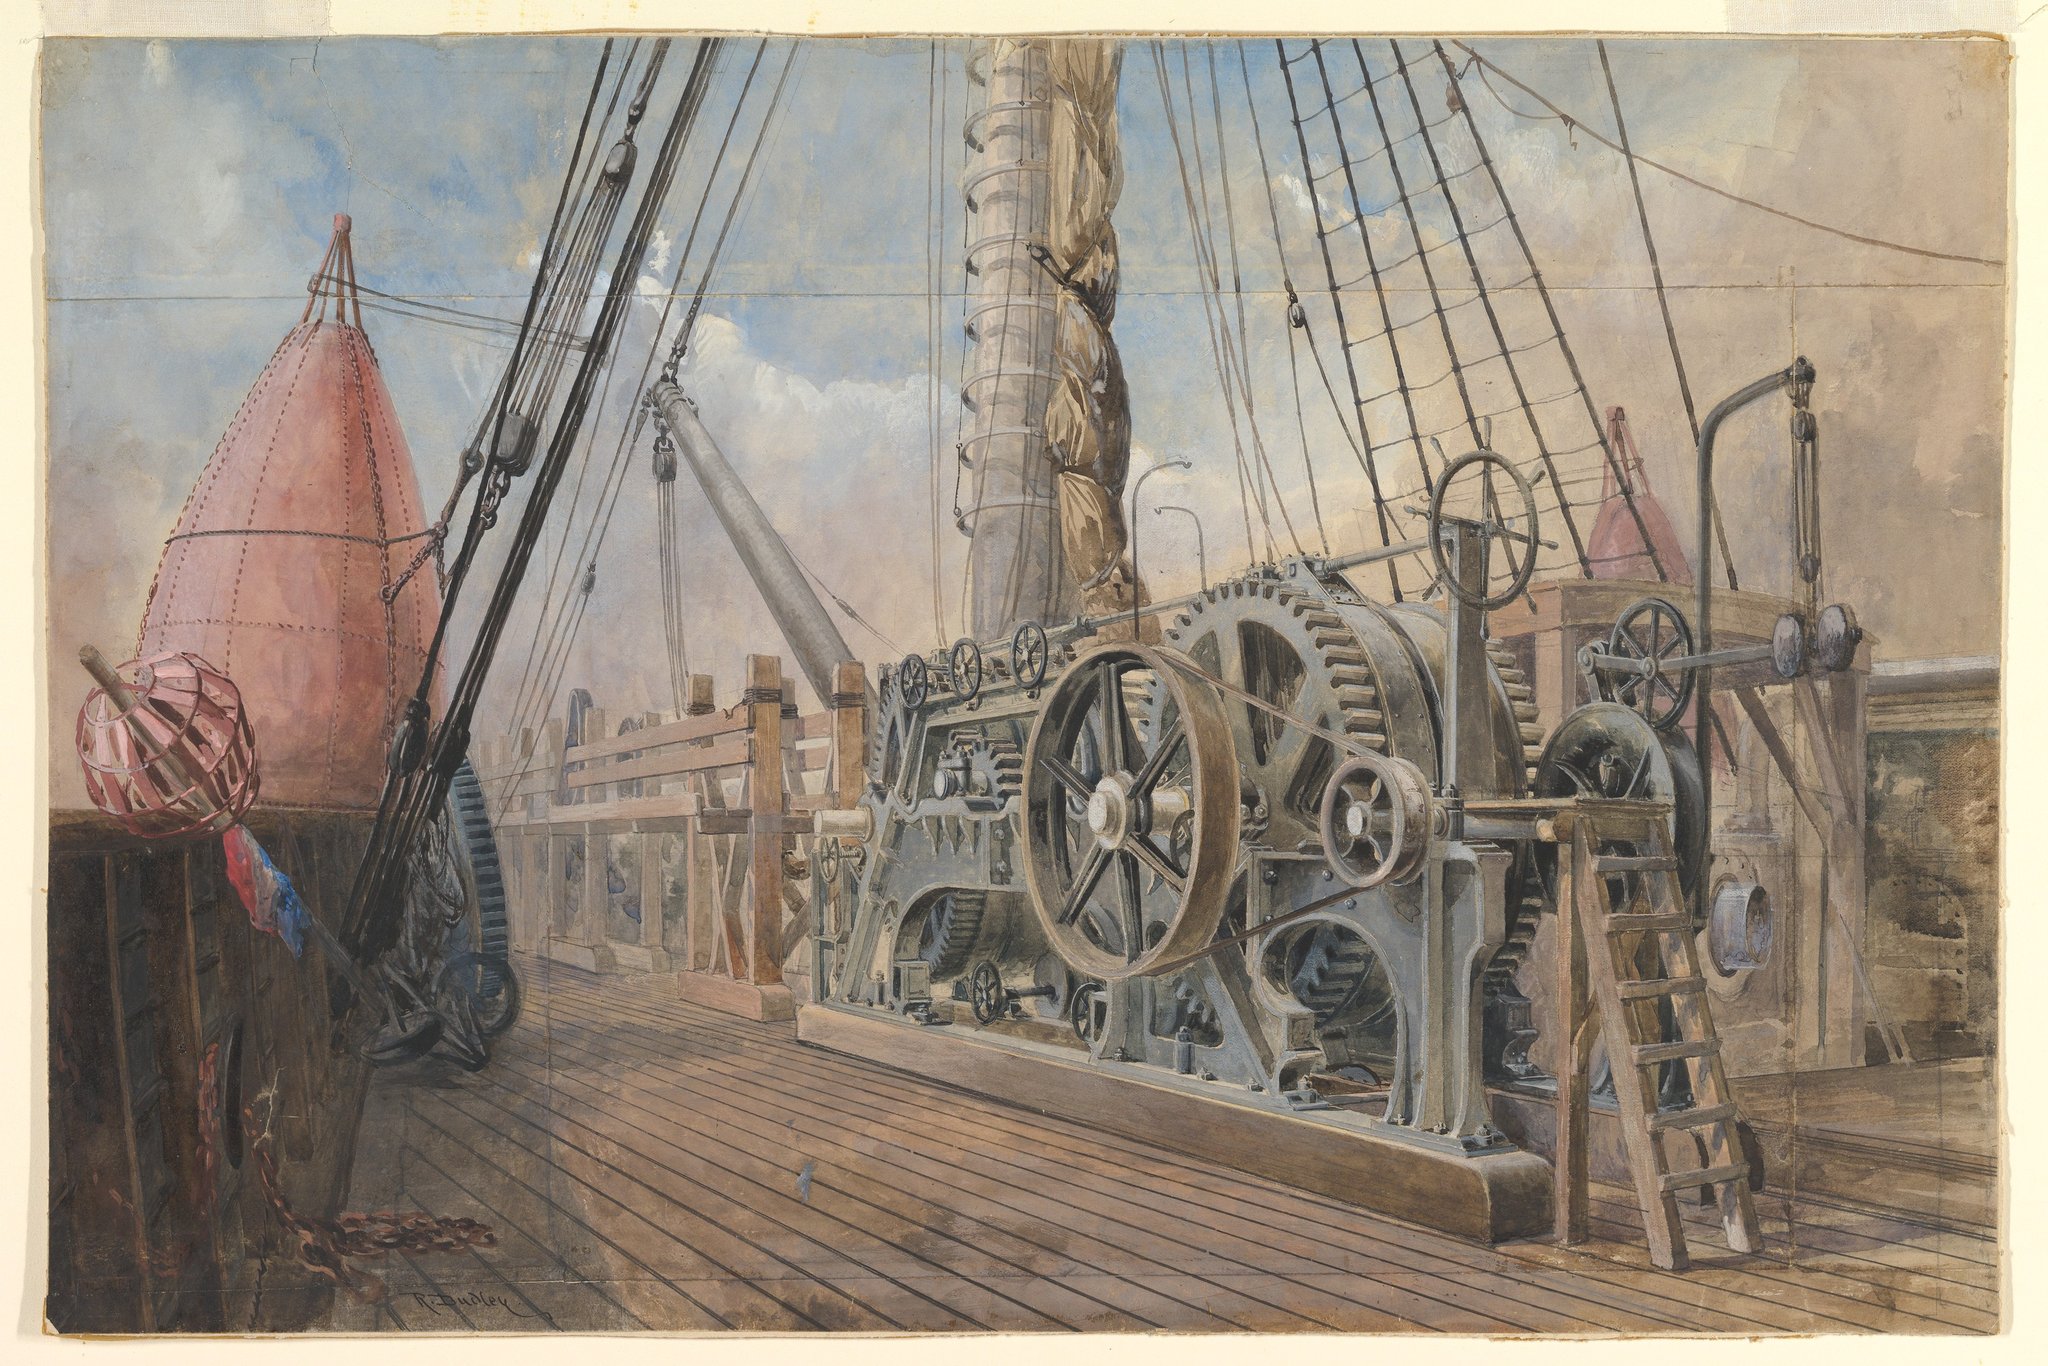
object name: drawing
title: Deck of the Great Eastern, the Cable Trough, etc., 1866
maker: robert charles dudley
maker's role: artist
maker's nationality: british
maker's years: 1826-1909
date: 1865-1866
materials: gouache, graphite, watercolor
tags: industry,ships,transatlantic cable